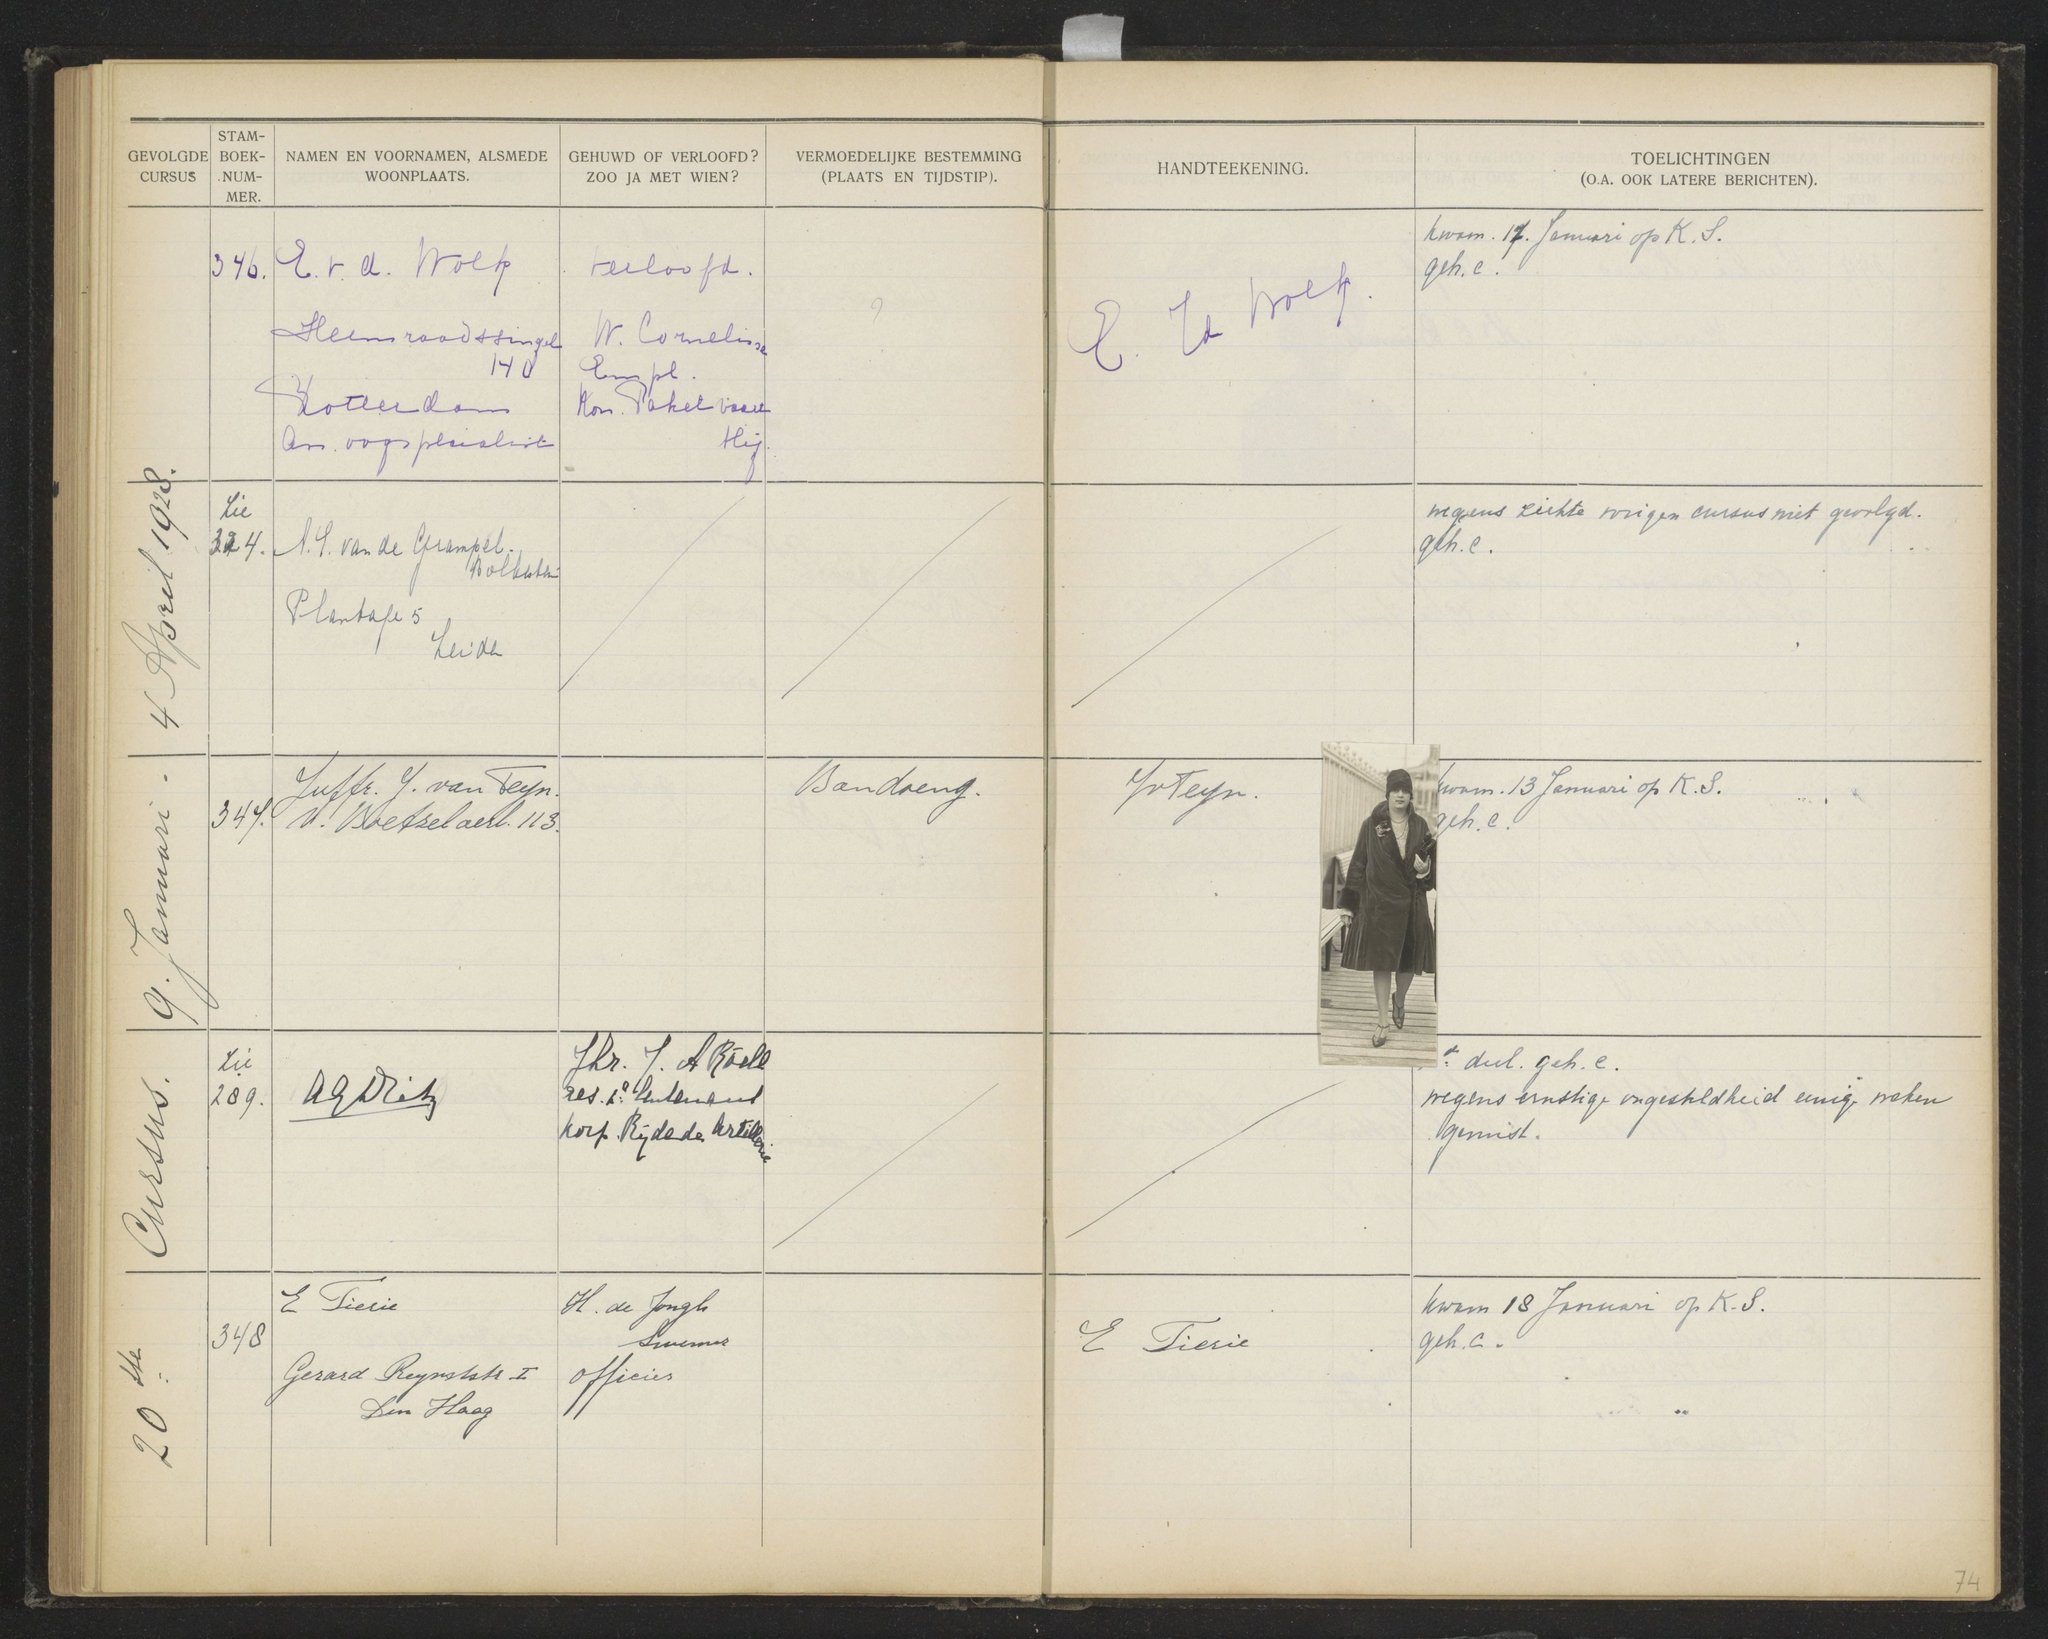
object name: photograph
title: Blad 74 uit Stamboek van de leerlingen der Koloniale School voor Meisjes en Vrouwen te 's-Gravenhage deel I (1921-1929)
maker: Anonymous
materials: paper, photographic support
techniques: photography, printing, writing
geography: the hague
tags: further education (+ pupil), further education, the hague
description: Twee pagina's met gegevens van de deelnemers aan de 20e driemaandelijkse cursus van 9 januari tot en met 4 april 1928, stamboeknummers 346 tot en met 348. Onderdeel van Stamboek van de leerlingen der Koloniale School voor Meisjes en Vrouwen te 's-Gravenhage deel I (1921-1929).